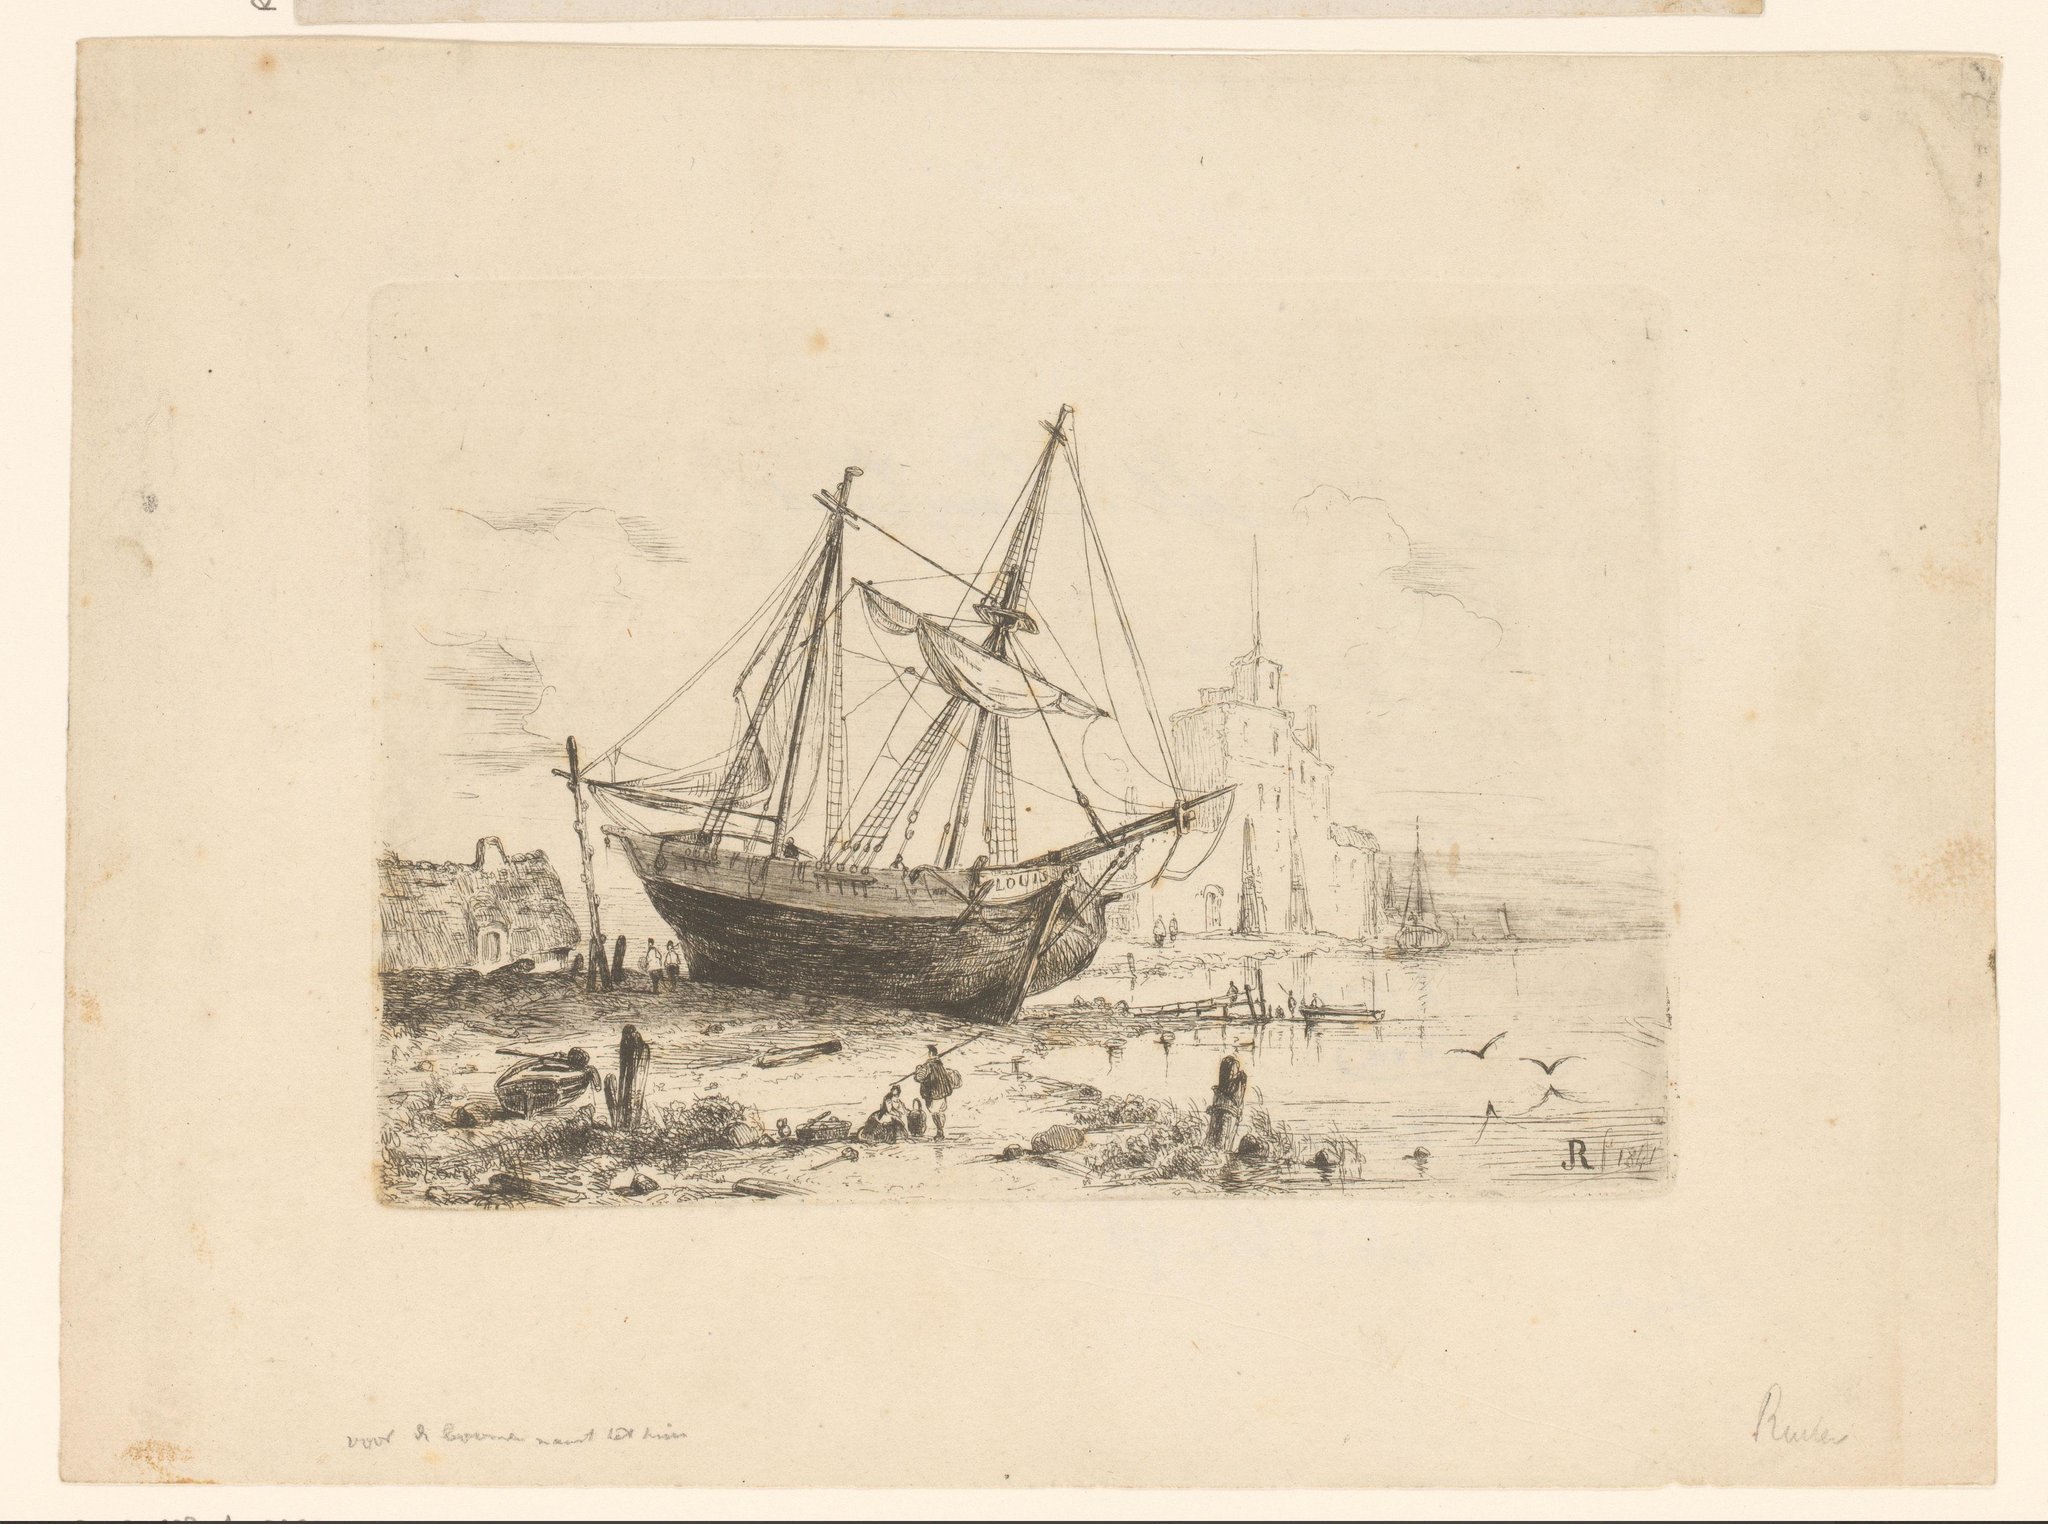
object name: print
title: Schip Louis aan land nabij een fort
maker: jean michel ruyten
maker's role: draughtsman, print maker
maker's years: 1813-1881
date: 1841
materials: paper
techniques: etching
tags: fortress, landscapes with waters, waterscapes, seascapes (in the temperate zone) (+ landscape with figures, staffage), ships, boats on land, beached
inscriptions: collector's mark: Lugt 2228